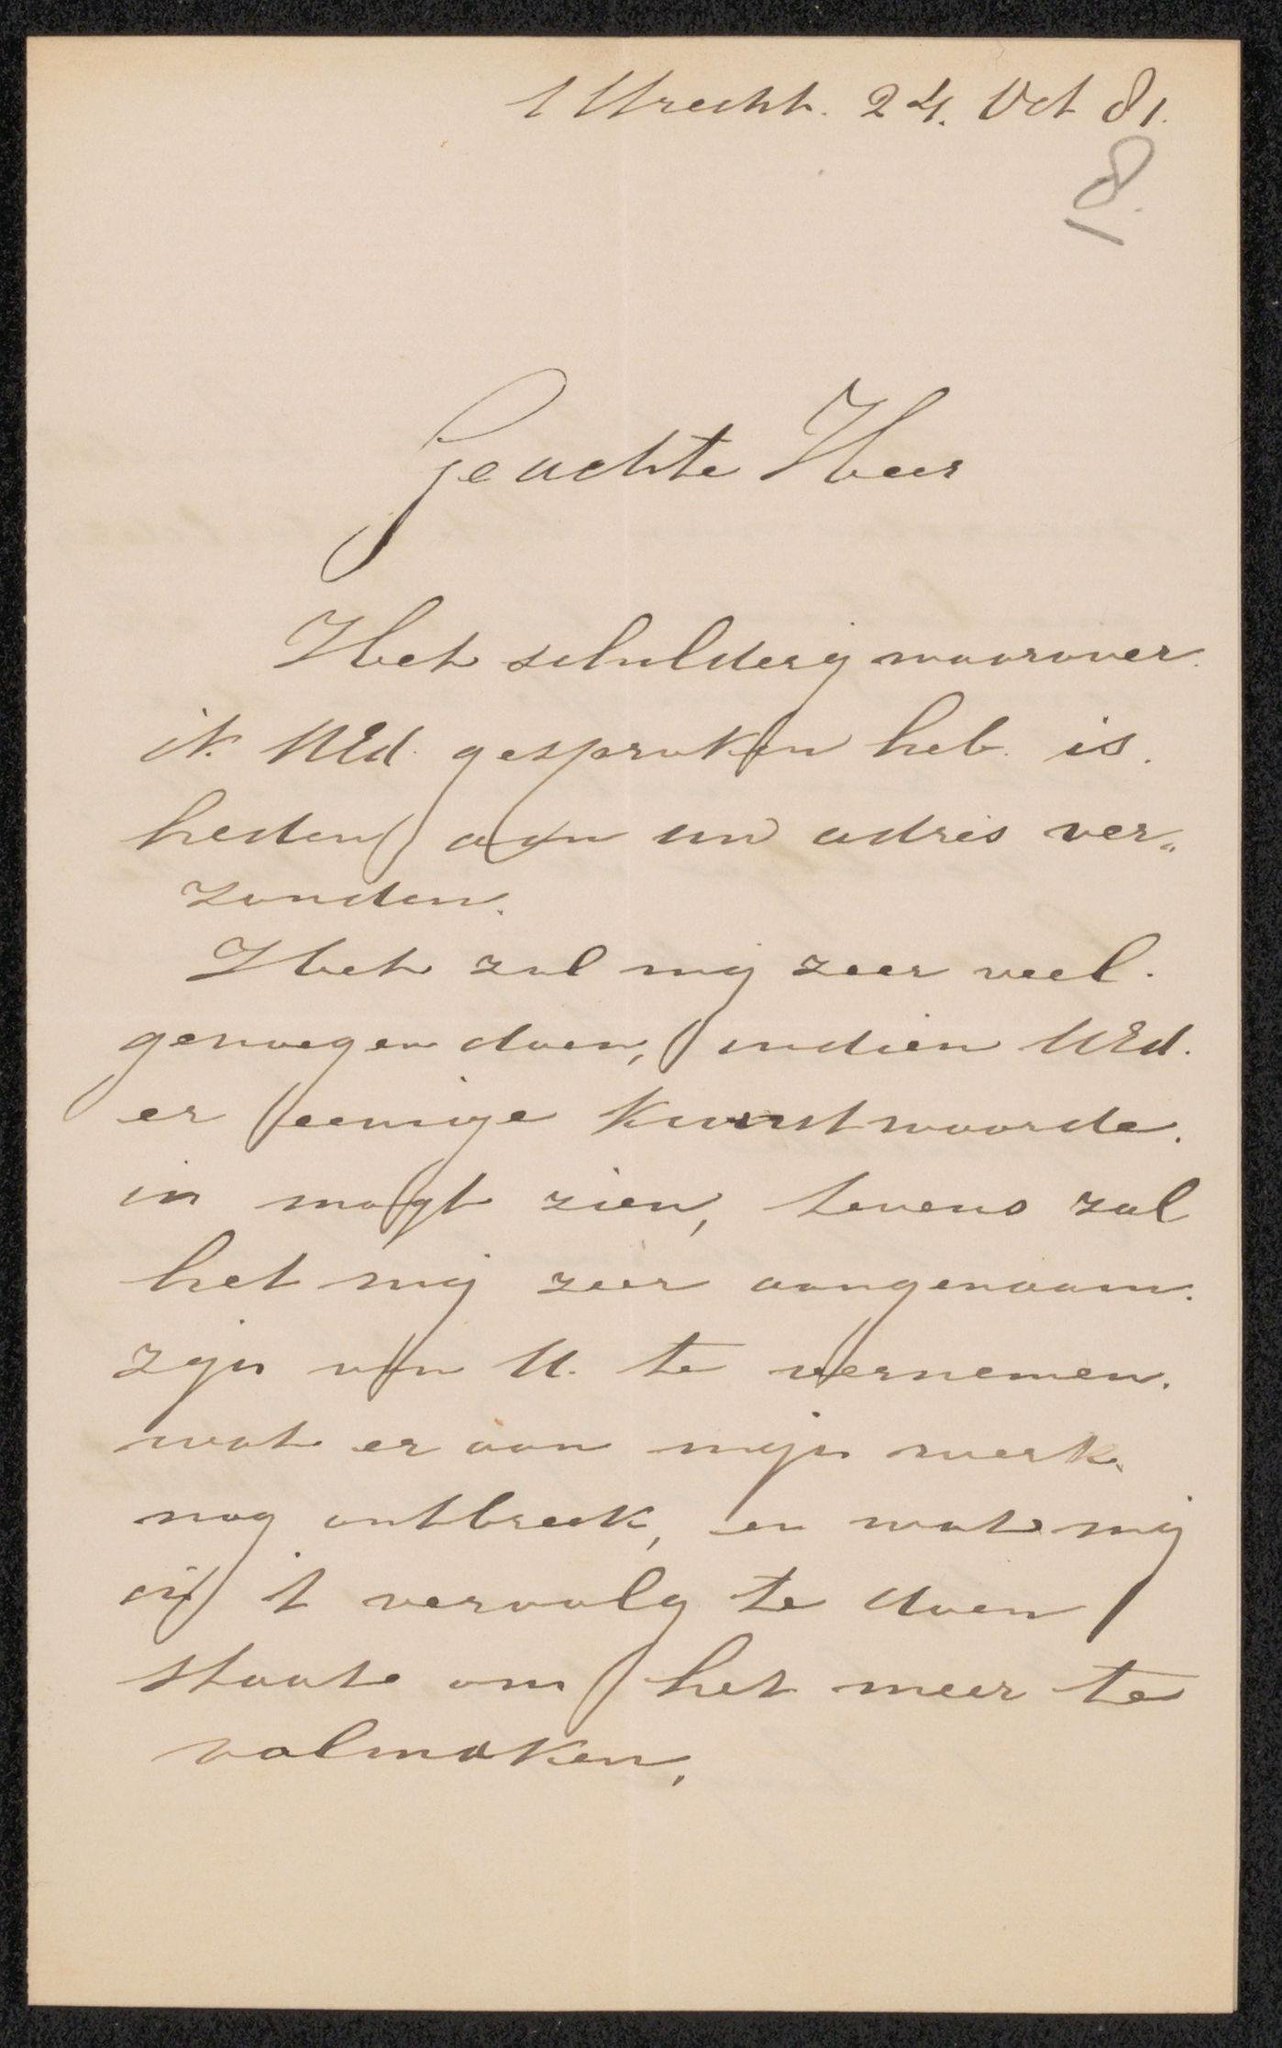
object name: letter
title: Brief aan Frans Buffa en Zonen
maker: dirk peter van lokhorst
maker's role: painter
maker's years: 1848-1894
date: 1881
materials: ink, paper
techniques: pen, writing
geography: utrecht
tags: publisher, art trade, art shop, painting (including book-illumination, miniature-painting)